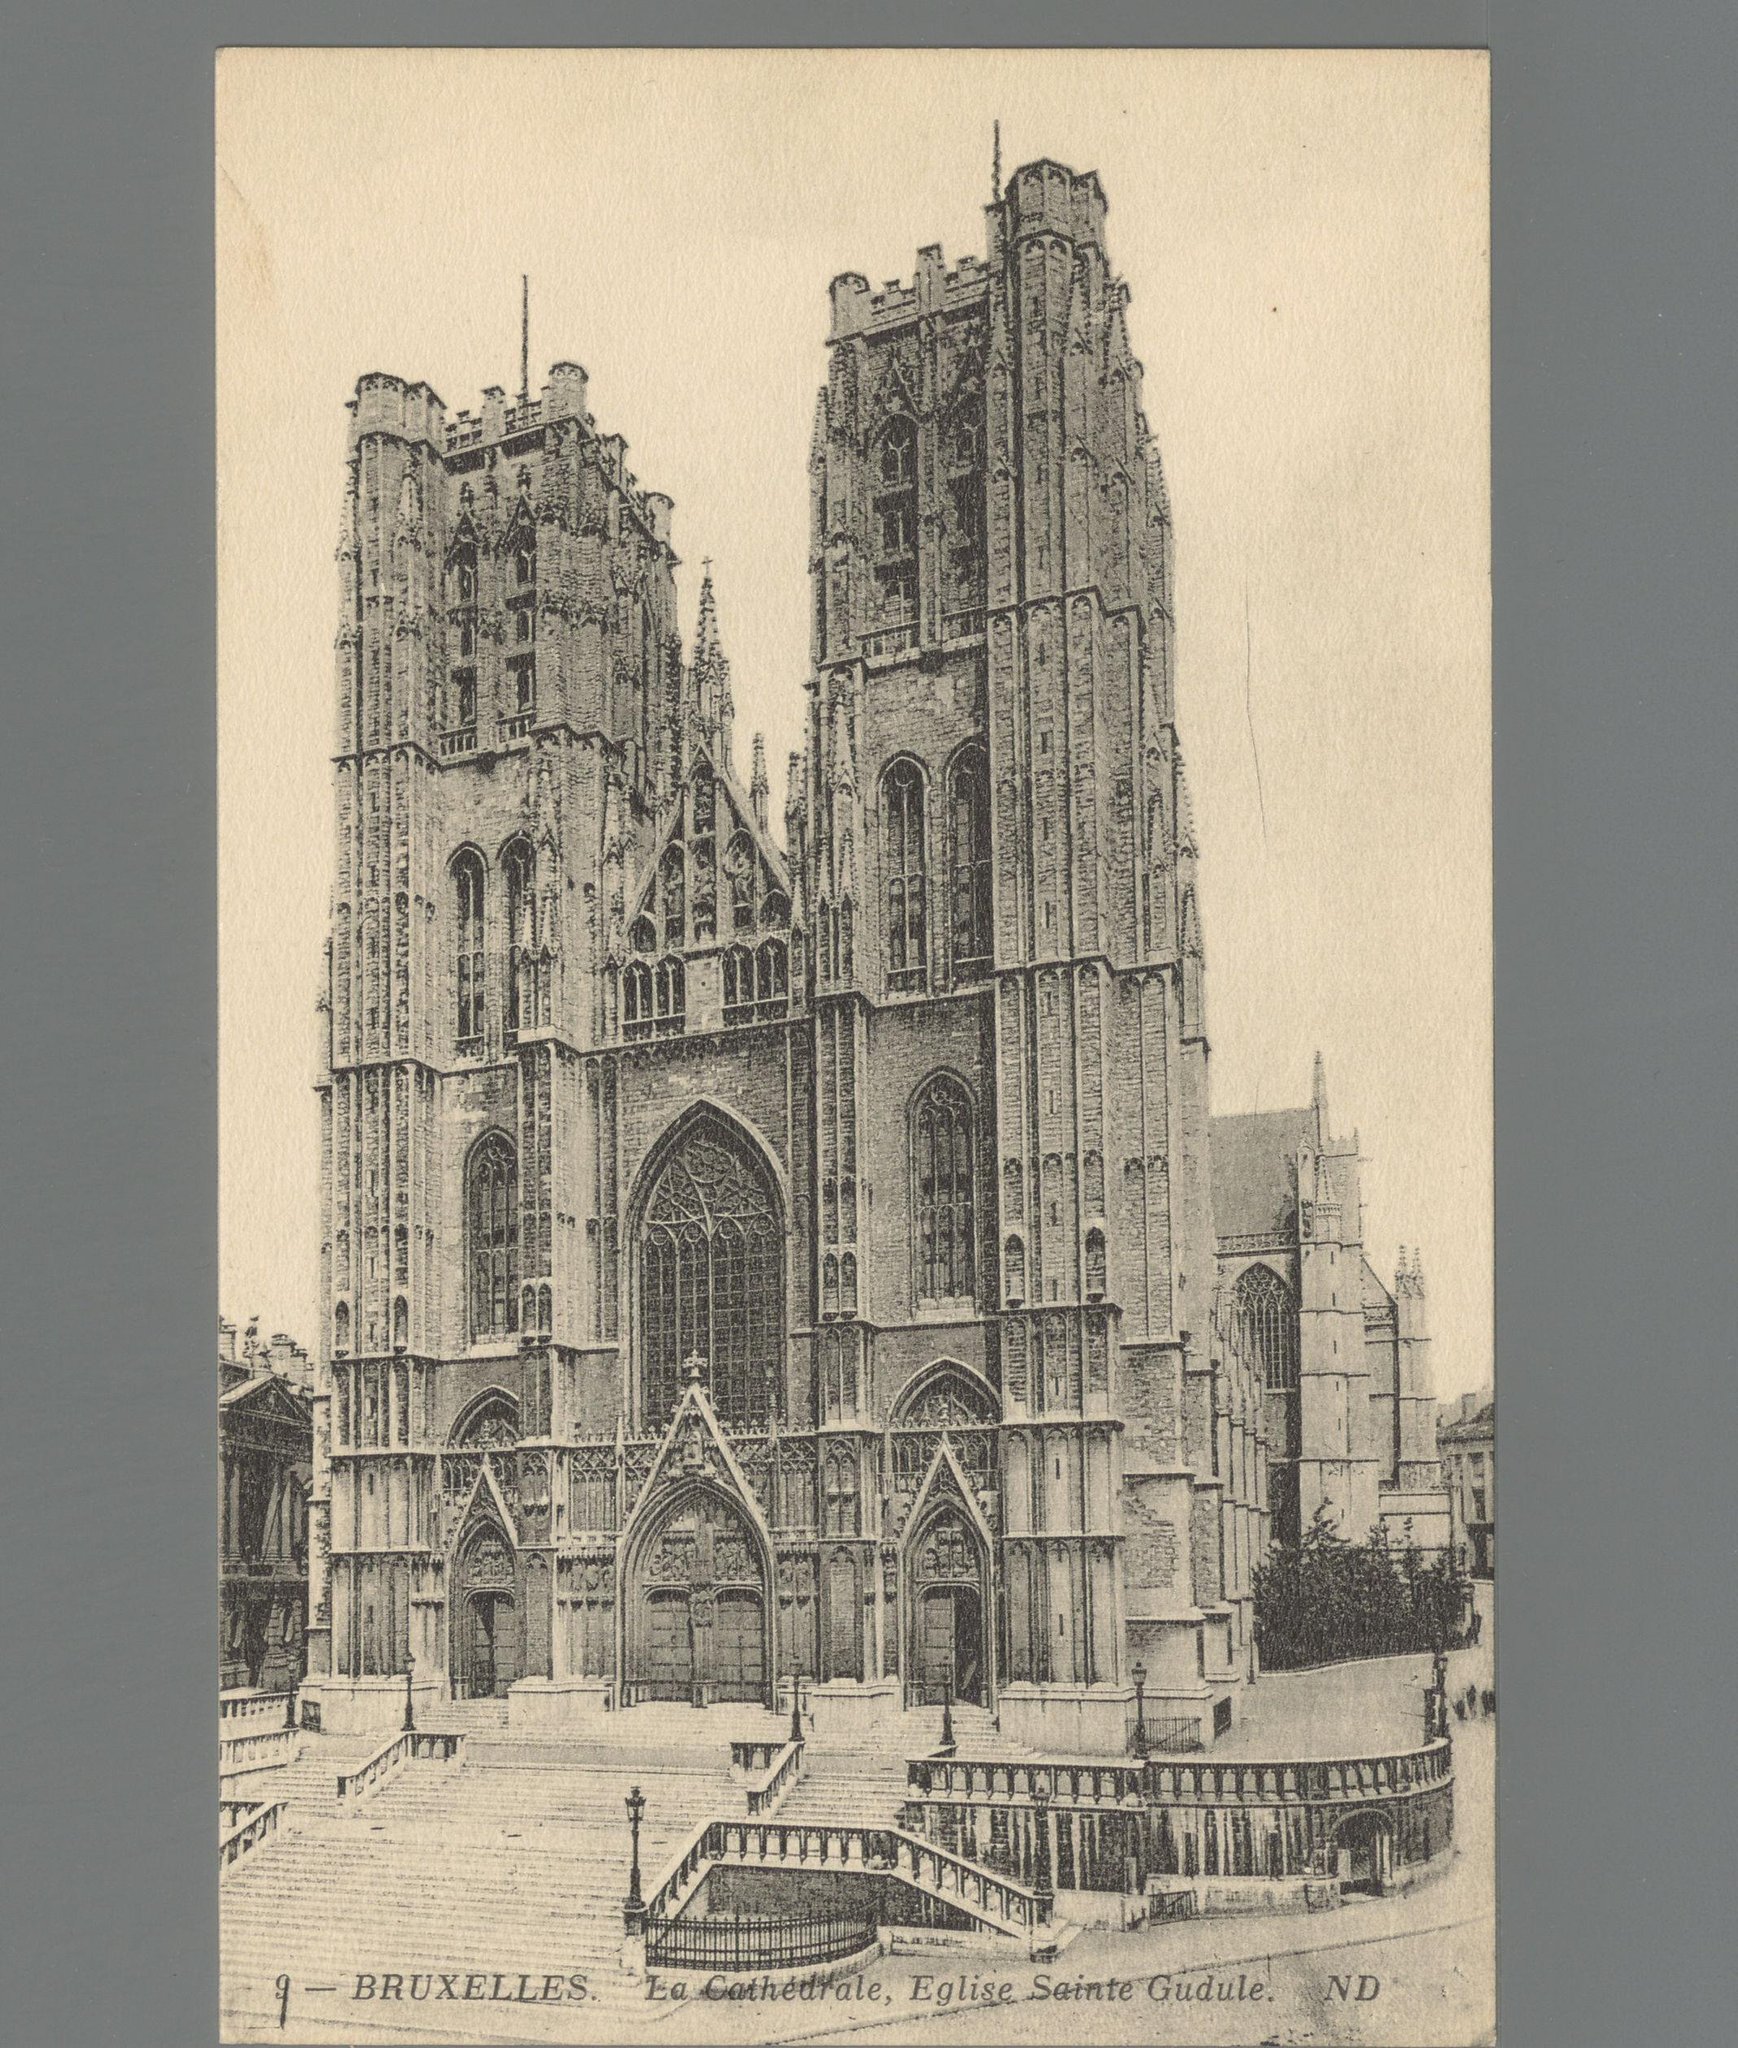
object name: ansichtkaart, prentbriefkaart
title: Bruxelles. La Cathédrale, Eglise Sainte Gudule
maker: Anonymous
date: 1906-1918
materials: cardboard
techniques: photograph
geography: paris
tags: city-view, and landscape with man-made constructions, church (exterior)